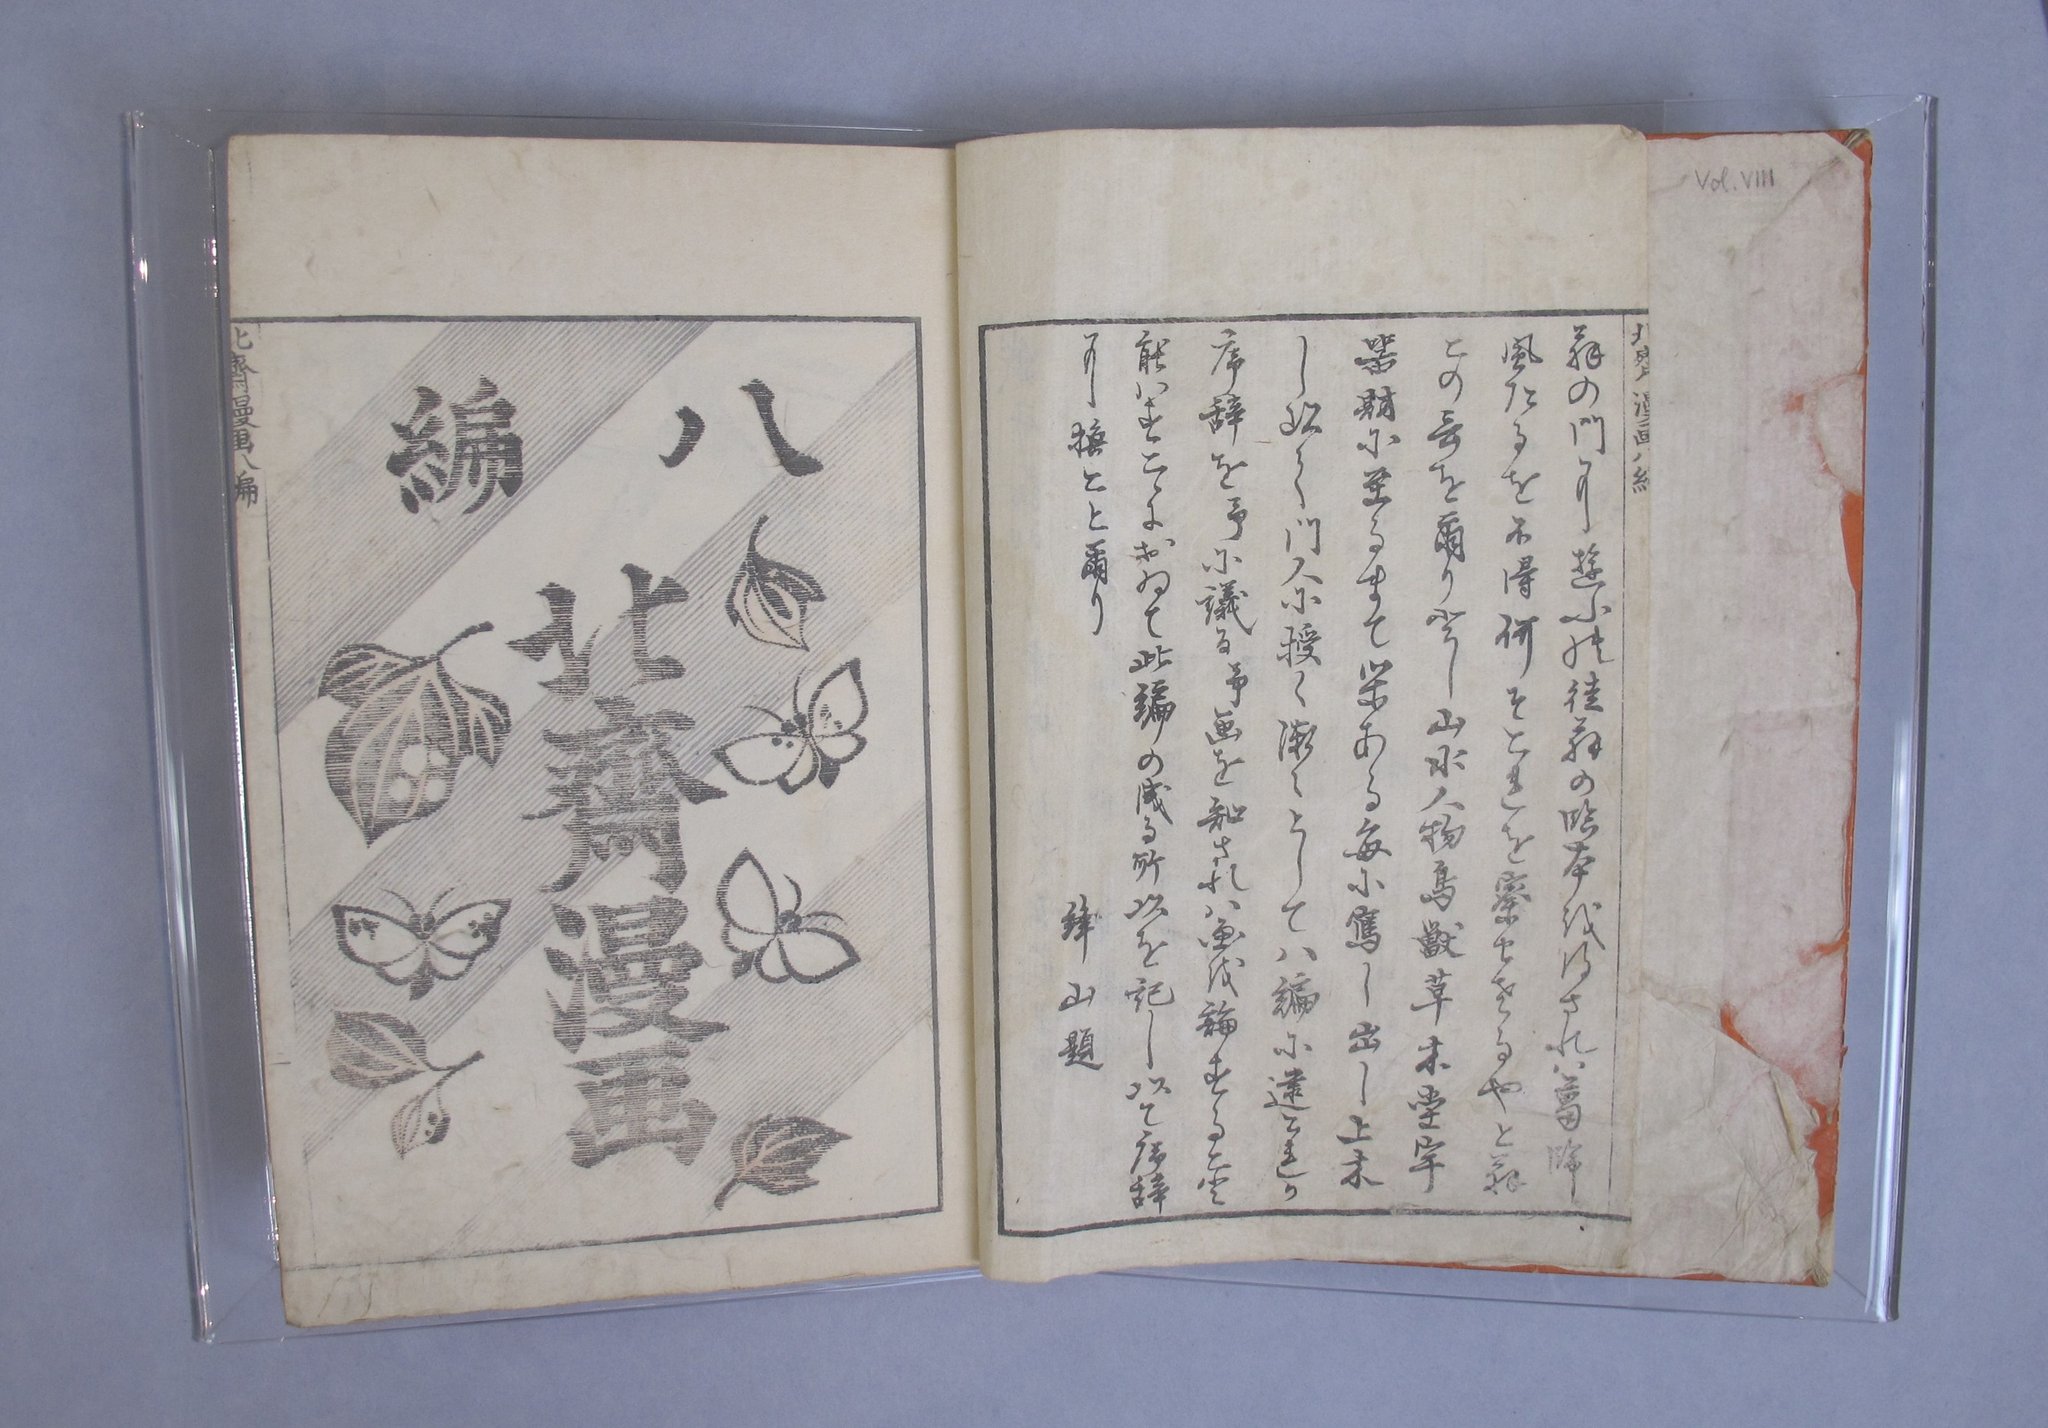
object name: illustrated book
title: Transmitting the Spirit, Revealing the Form of Things: Hokusai Sketchbooks, volume 8 (Denshin kaishu: Hokusai manga, hachihen)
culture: japanese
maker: katsushika hokusai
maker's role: artist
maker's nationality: japanese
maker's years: 1760-1849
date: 1817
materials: ink, paper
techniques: woodblock print